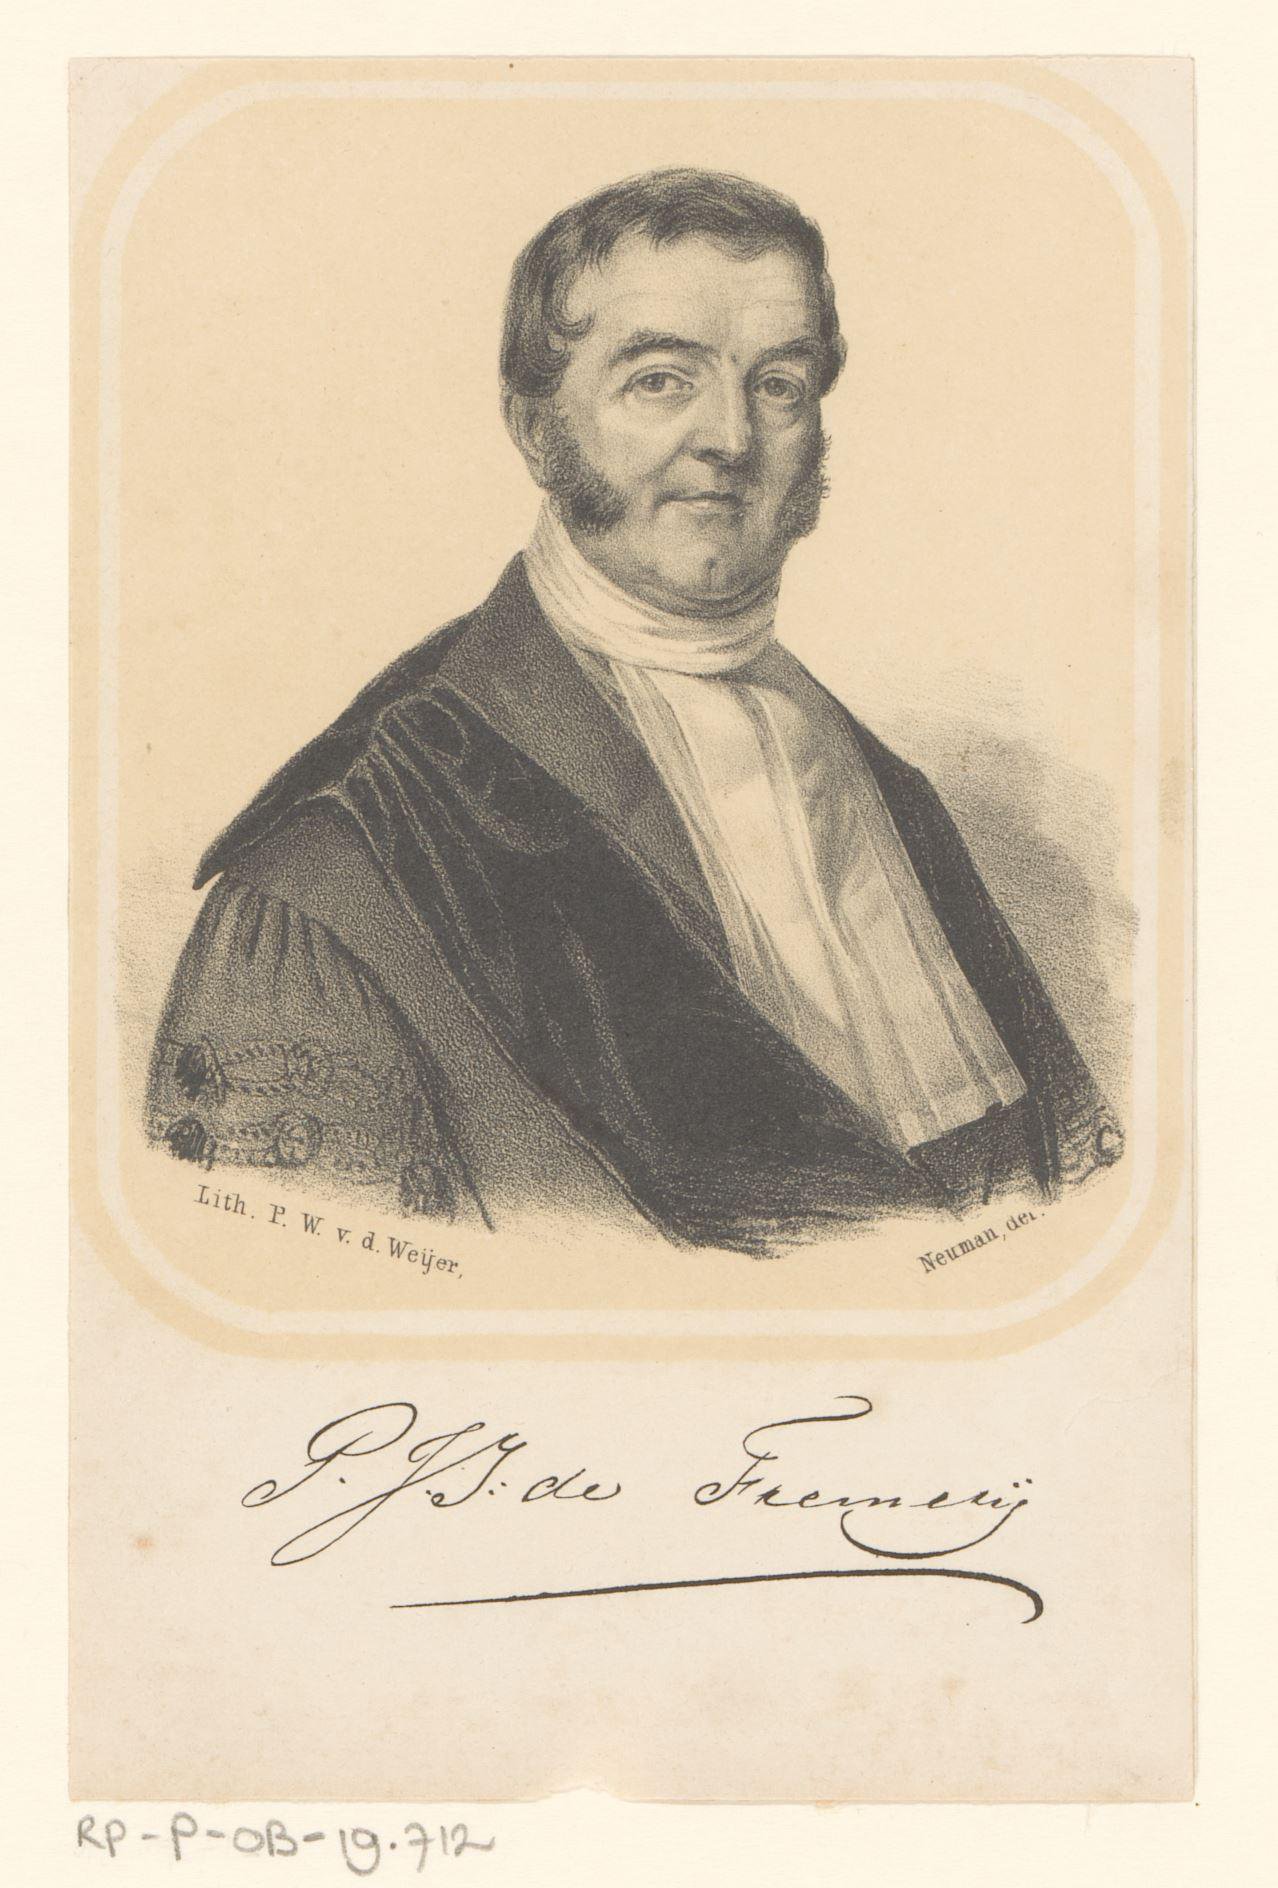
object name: print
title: Portret van Petrus Johannes Isaacus de Frémery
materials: paper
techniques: tone lithography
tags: historical persons (+ (full) bust portrait)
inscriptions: collector's mark: Lugt 2228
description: Onder het portret de signatuur van de geportretteerde.